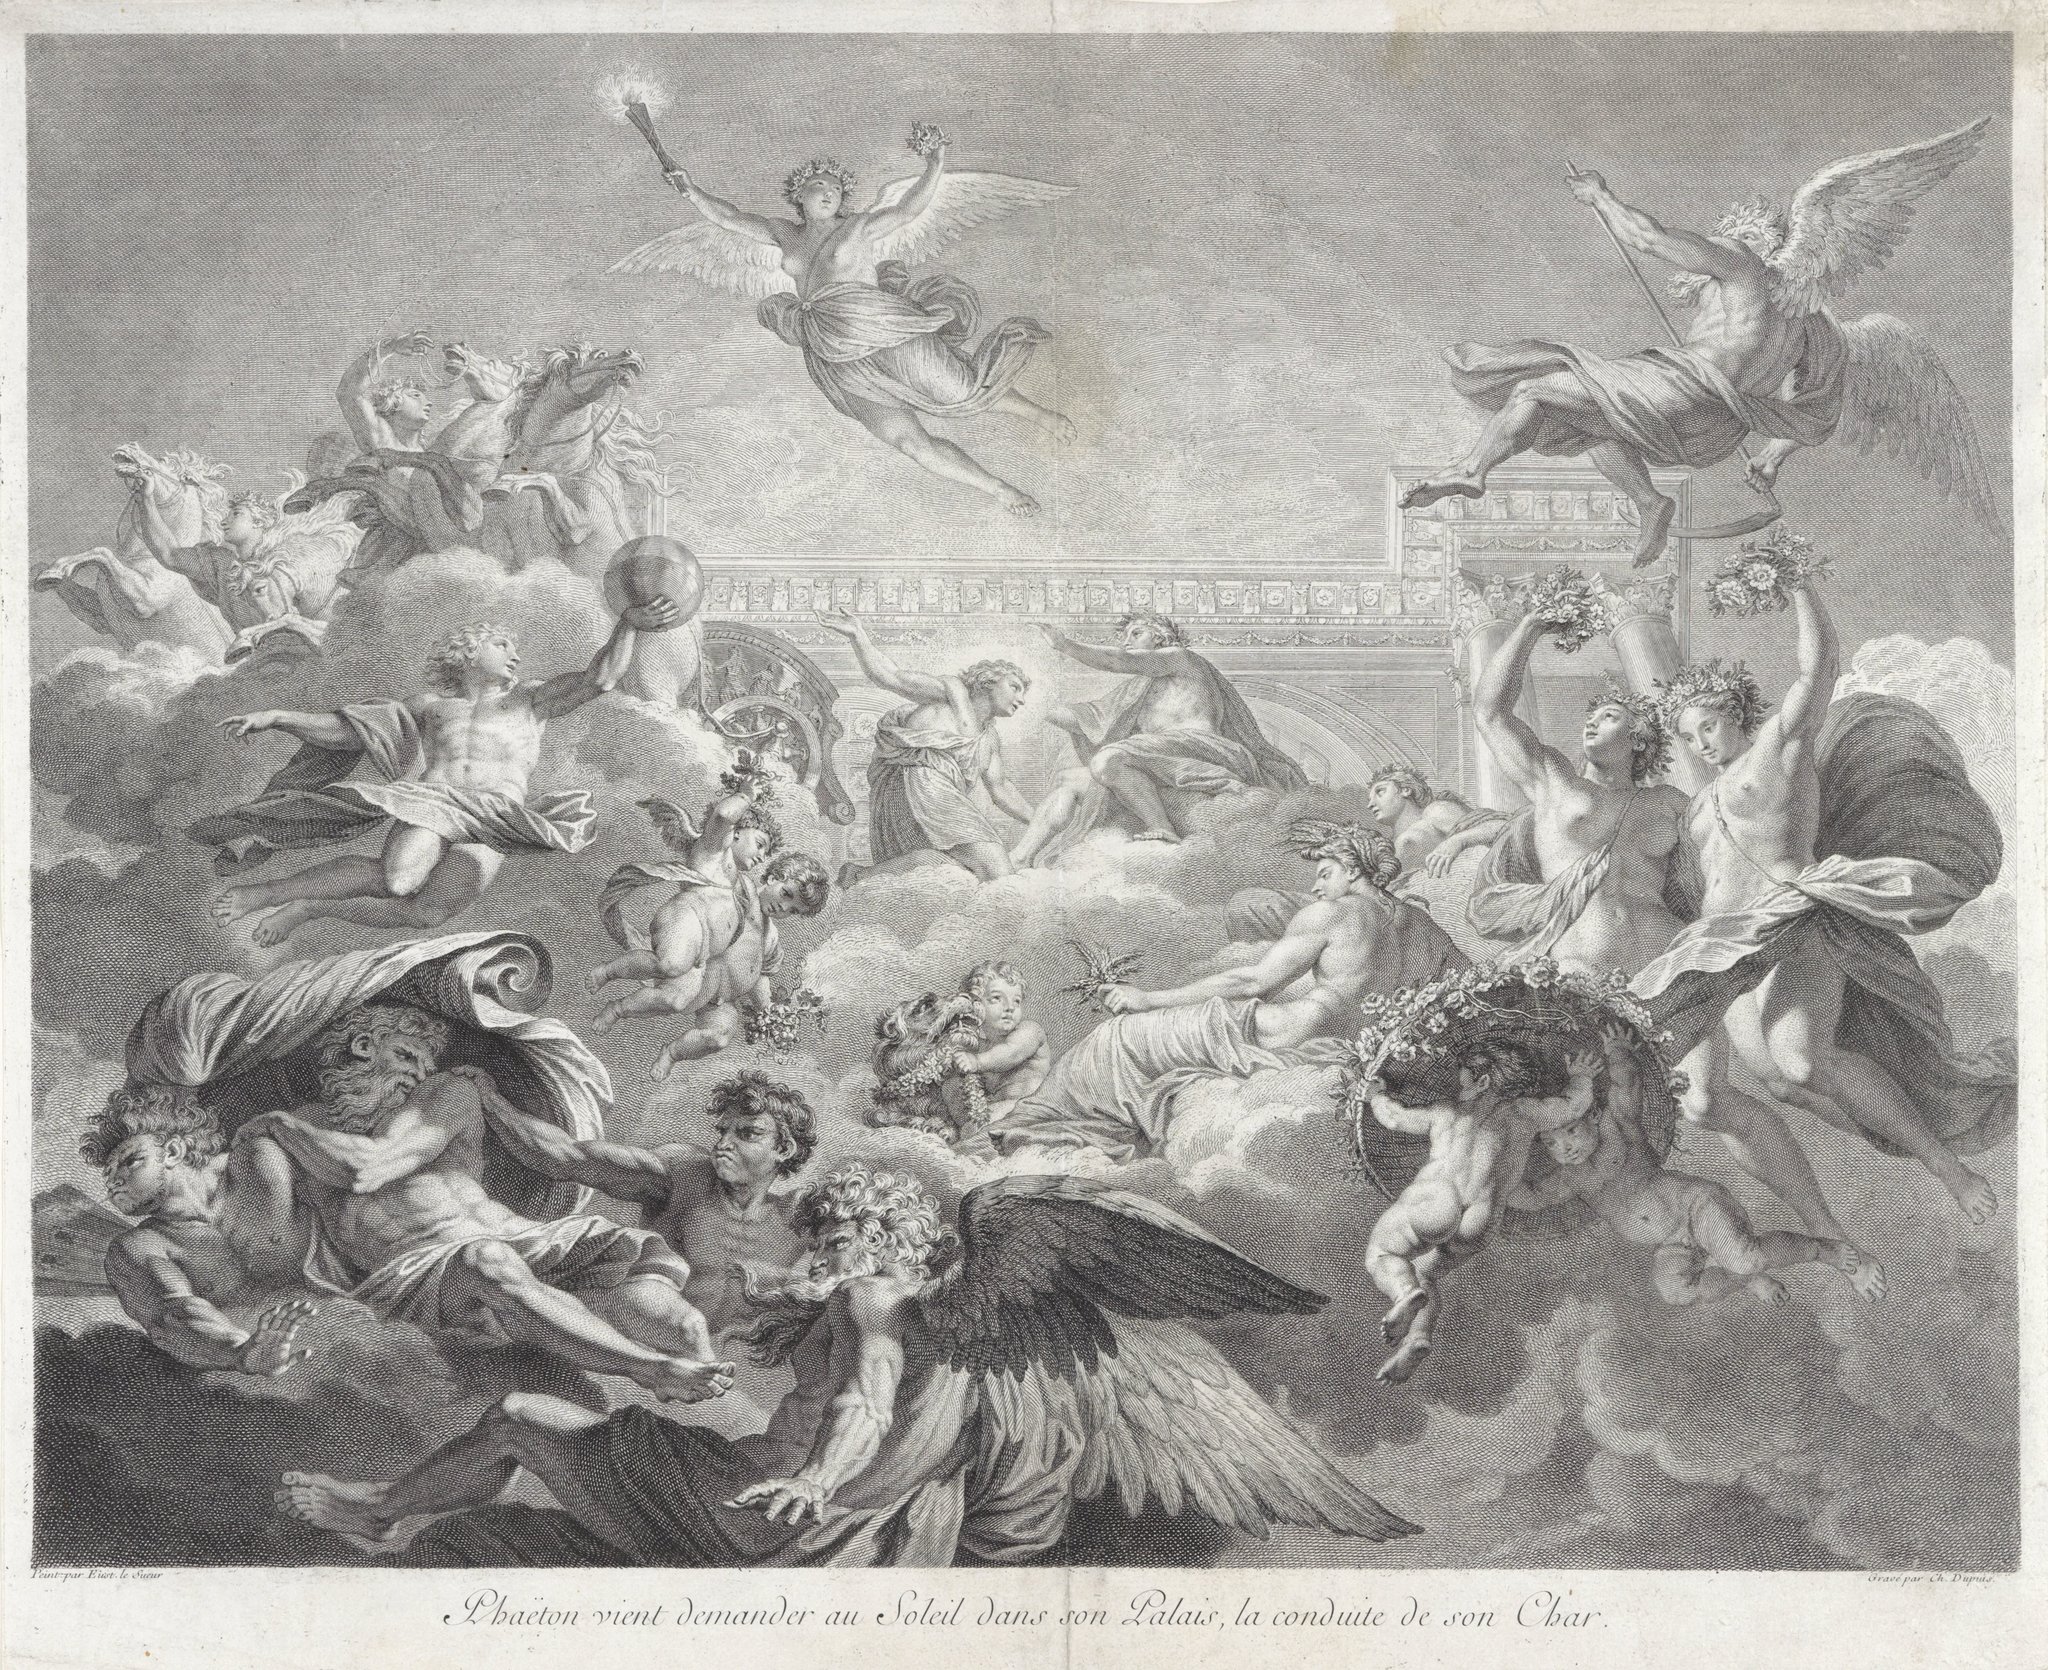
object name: print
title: Phaëton en Apollo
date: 1720-1733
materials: paper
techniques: engraving, etching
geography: paris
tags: phaethon asks apollo (sol) for the chariot of the sun, (story of) aurora (eos); 'aurora' (ripa), father time, man with wings and scythe, gods of the winds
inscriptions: collector's mark: Lugt 2228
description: Phaëthon smeekt de zonnegod Apollo, om een dag in de zonnewagen te mogen rijden. Apollo spreidt zijn handen boven het hoofd van zijn zoon. Links houden mannen de paarden voor de zonnewagen in toom. Aurora, de godin van de dageraad, vliegt midden boven met haar toorts. Rechts Vader Tijd met zijn zeis, Ceres met korenaren, en de Uren met bloemen in de handen. Linksonder de Vier Winden. Naar het schilderij in de Chambre des Muses in het Hôtel Lambert. Prent maakt deel uit van een serie prenten naar de schilderijen in het Hôtel Lambert te Parijs.